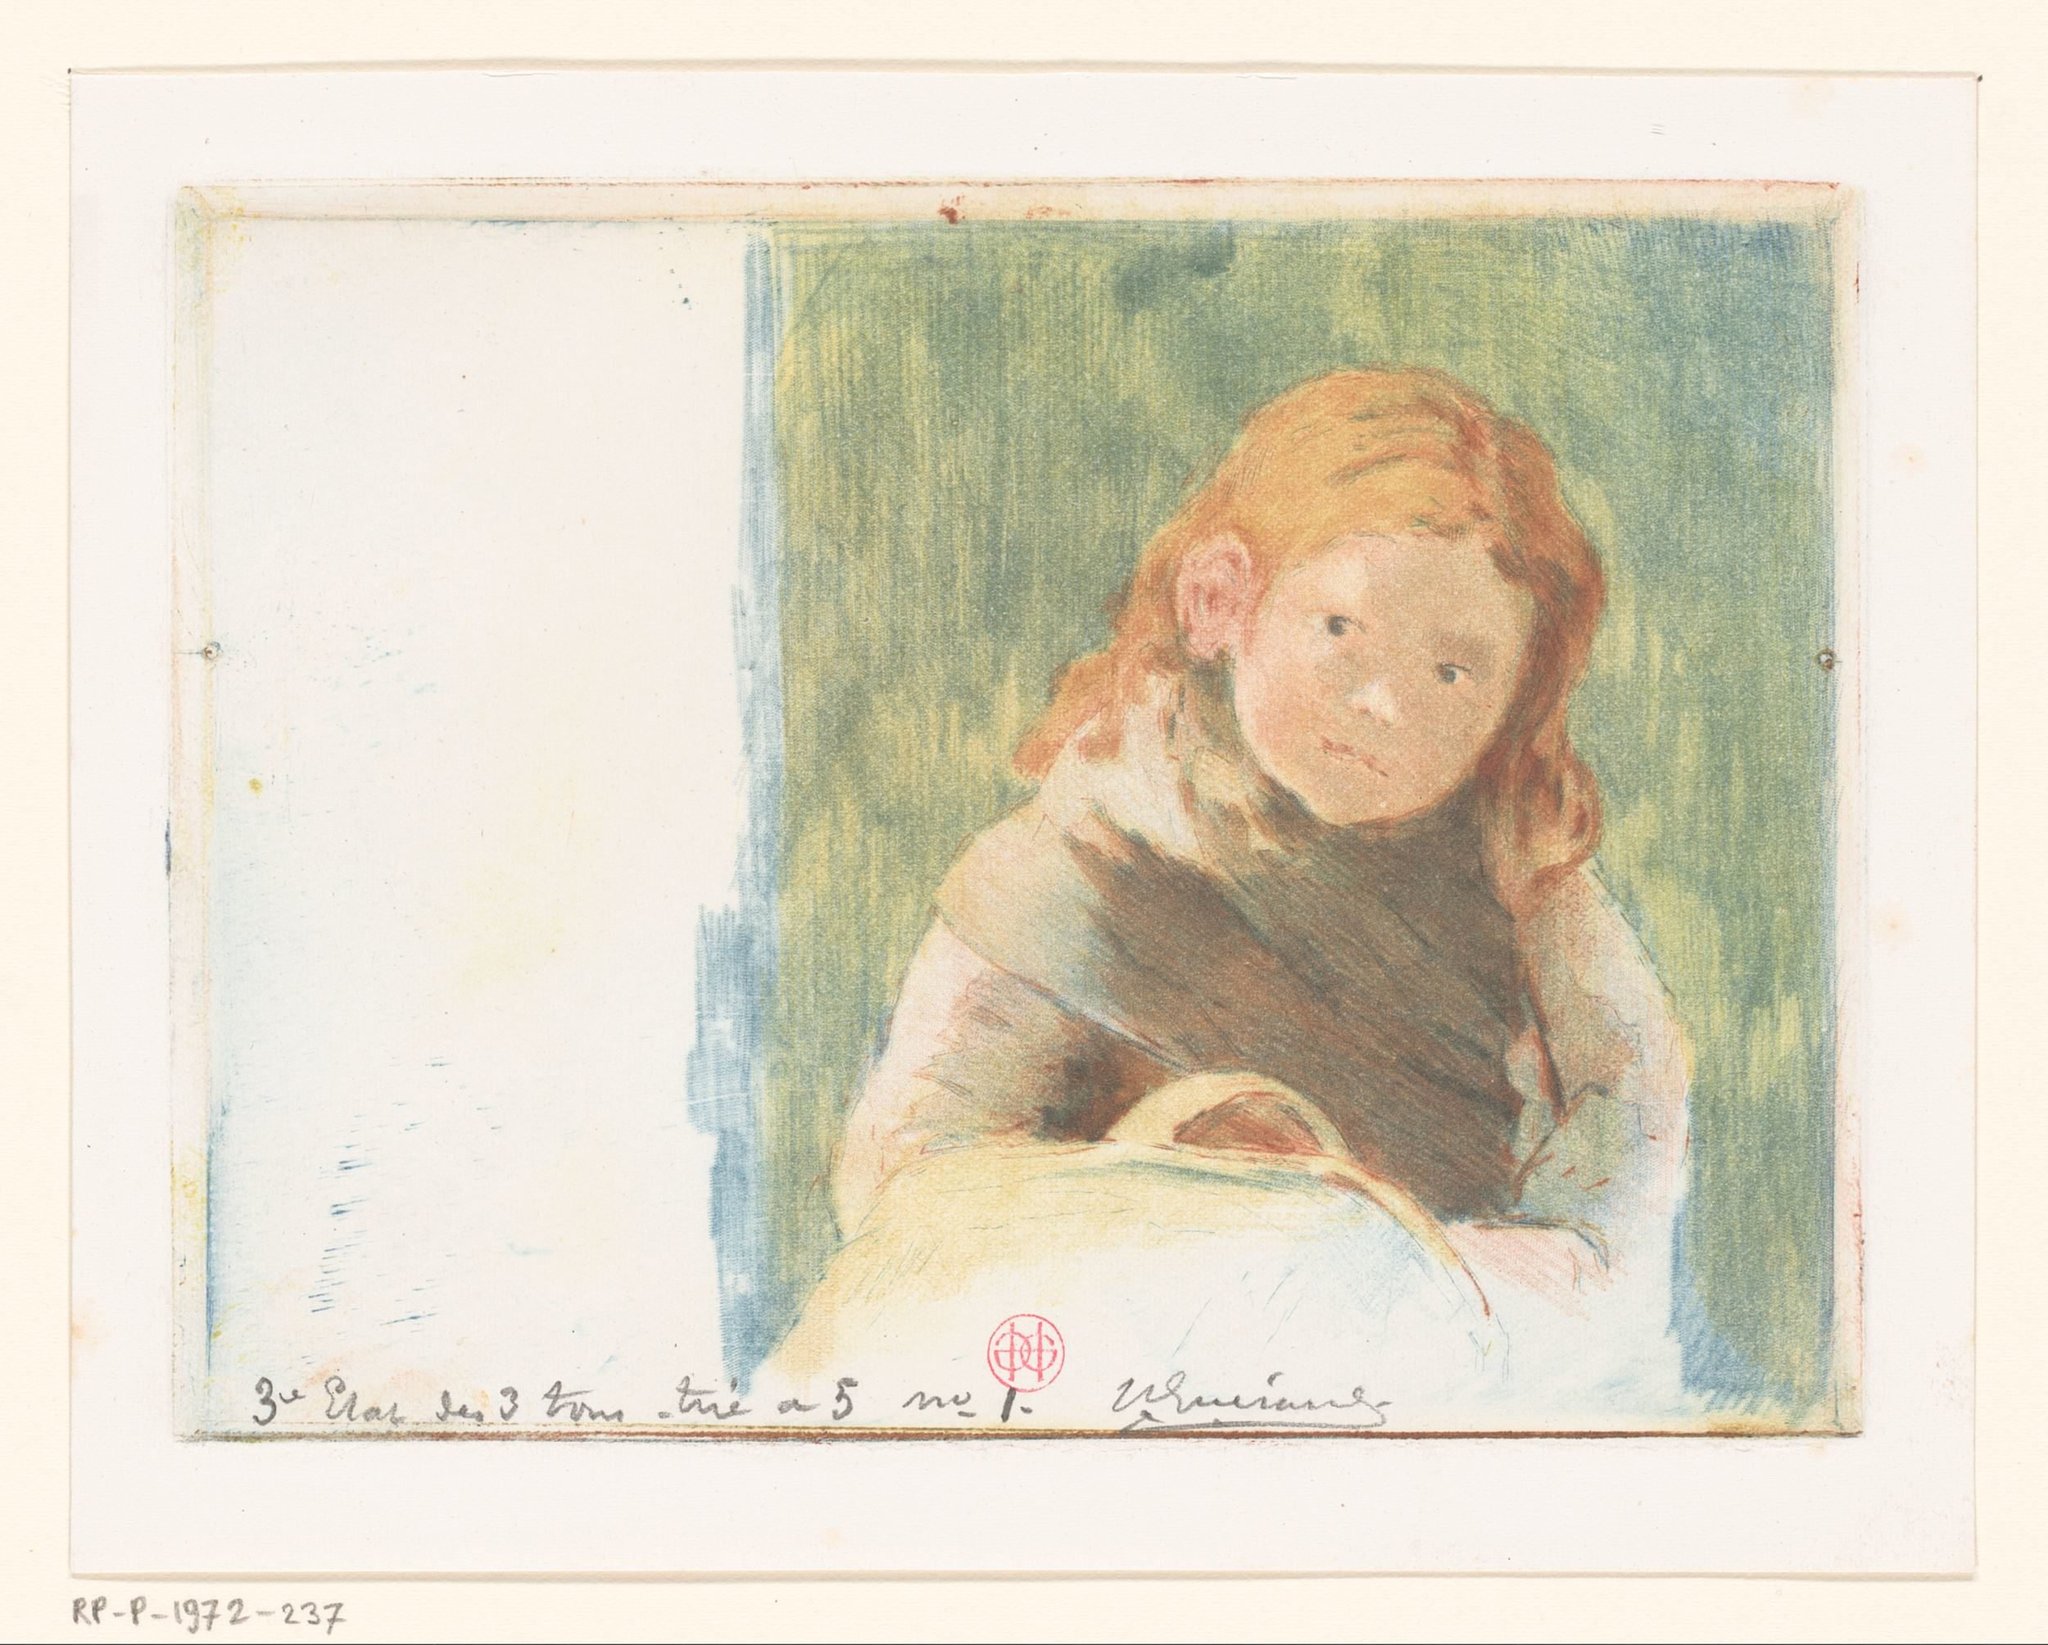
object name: print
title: Meisje met mand in een bloemenweide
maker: henri charles guérard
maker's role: print maker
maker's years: 1846-1897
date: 1856-1897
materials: paper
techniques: roulette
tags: meadow, pasture, container made of plant material other than wood: basket, girl (child between toddler and youth)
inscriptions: stamp: Lugt 1157, annotation: ‘3e Etat de 3 tons - tiré a 5 no. 1.’, collector's mark: Lugt 2228, collector's mark: Lugt 2760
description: Het Rijksmuseum beschikt over negentien drukken van dezelfde voorstelling (RP-P-1972-234 t/m RP-P-1972-252) in verschillende staten en tonen. Volgens een annotatie betreft dit de derde staat.